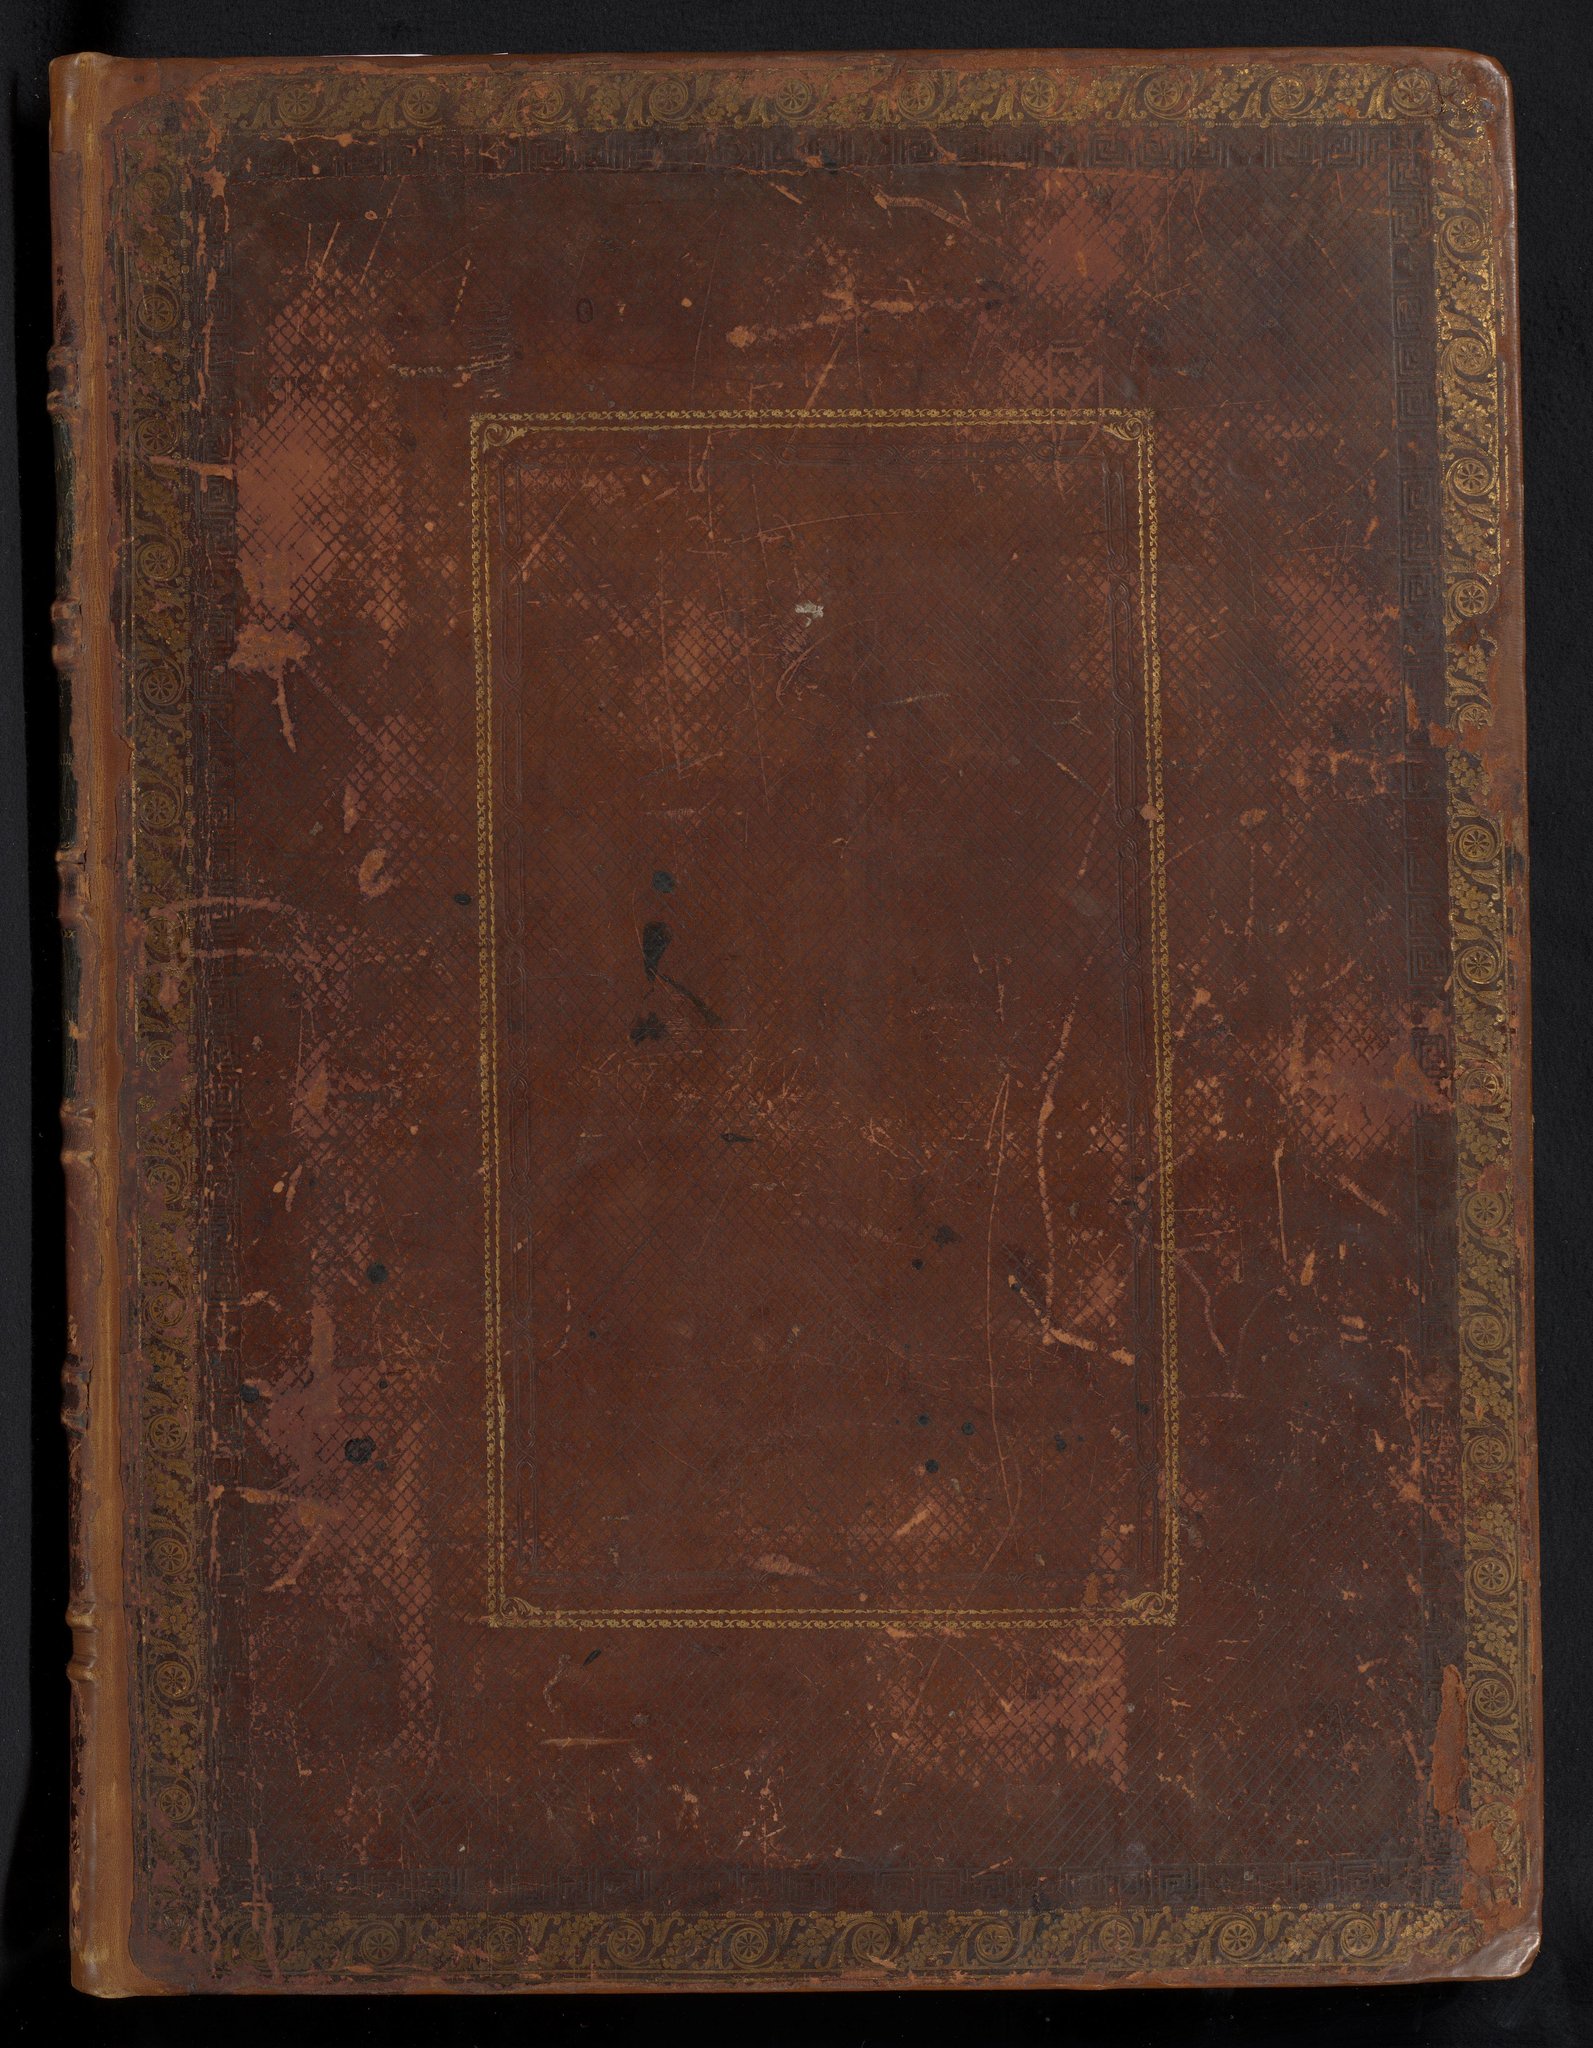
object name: tekeningenalbum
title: Original Drawings, Alexander the Great by Leonard Bramer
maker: leonaert bramer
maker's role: draughtsman, painter, print maker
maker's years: 1596-1674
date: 1655-1665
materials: paint, gold leaf, ink, leather, paper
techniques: bookbinding, printing, brush, etching, hand coloring, marbling, pen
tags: (story of) alexander the great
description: Album met 48 tekeningen, twee handgeschreven tekstbladen en een geëtst portret op 50 albumbladen. De tekeningen door Leonaert Bramer bevatten scènes uit het leven van Alexander de Grote.